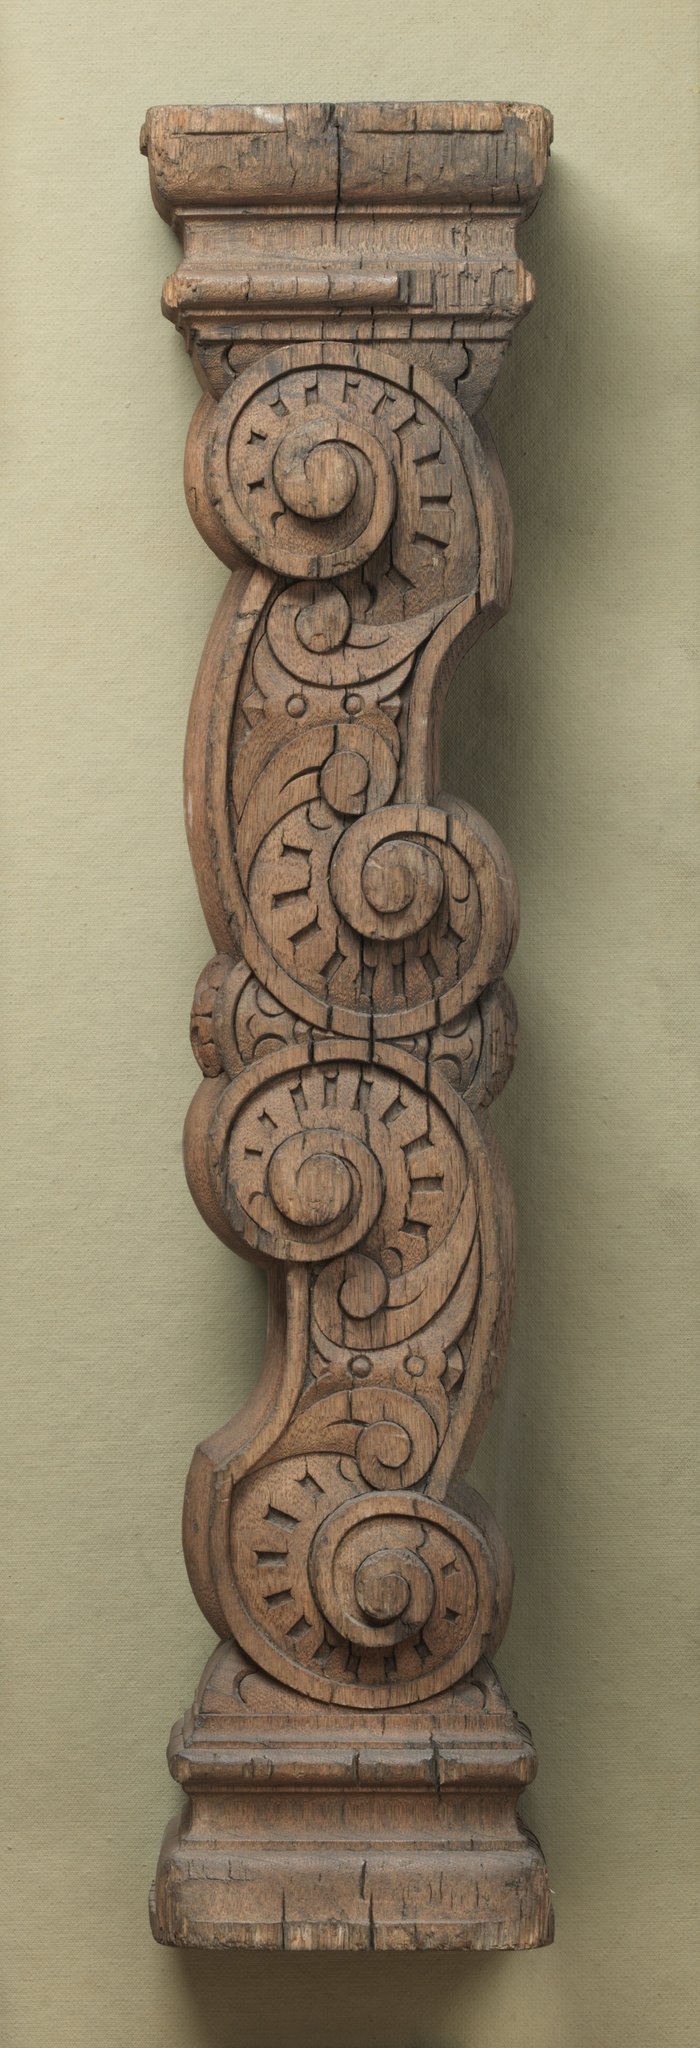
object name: baluster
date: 1567-1633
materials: wood